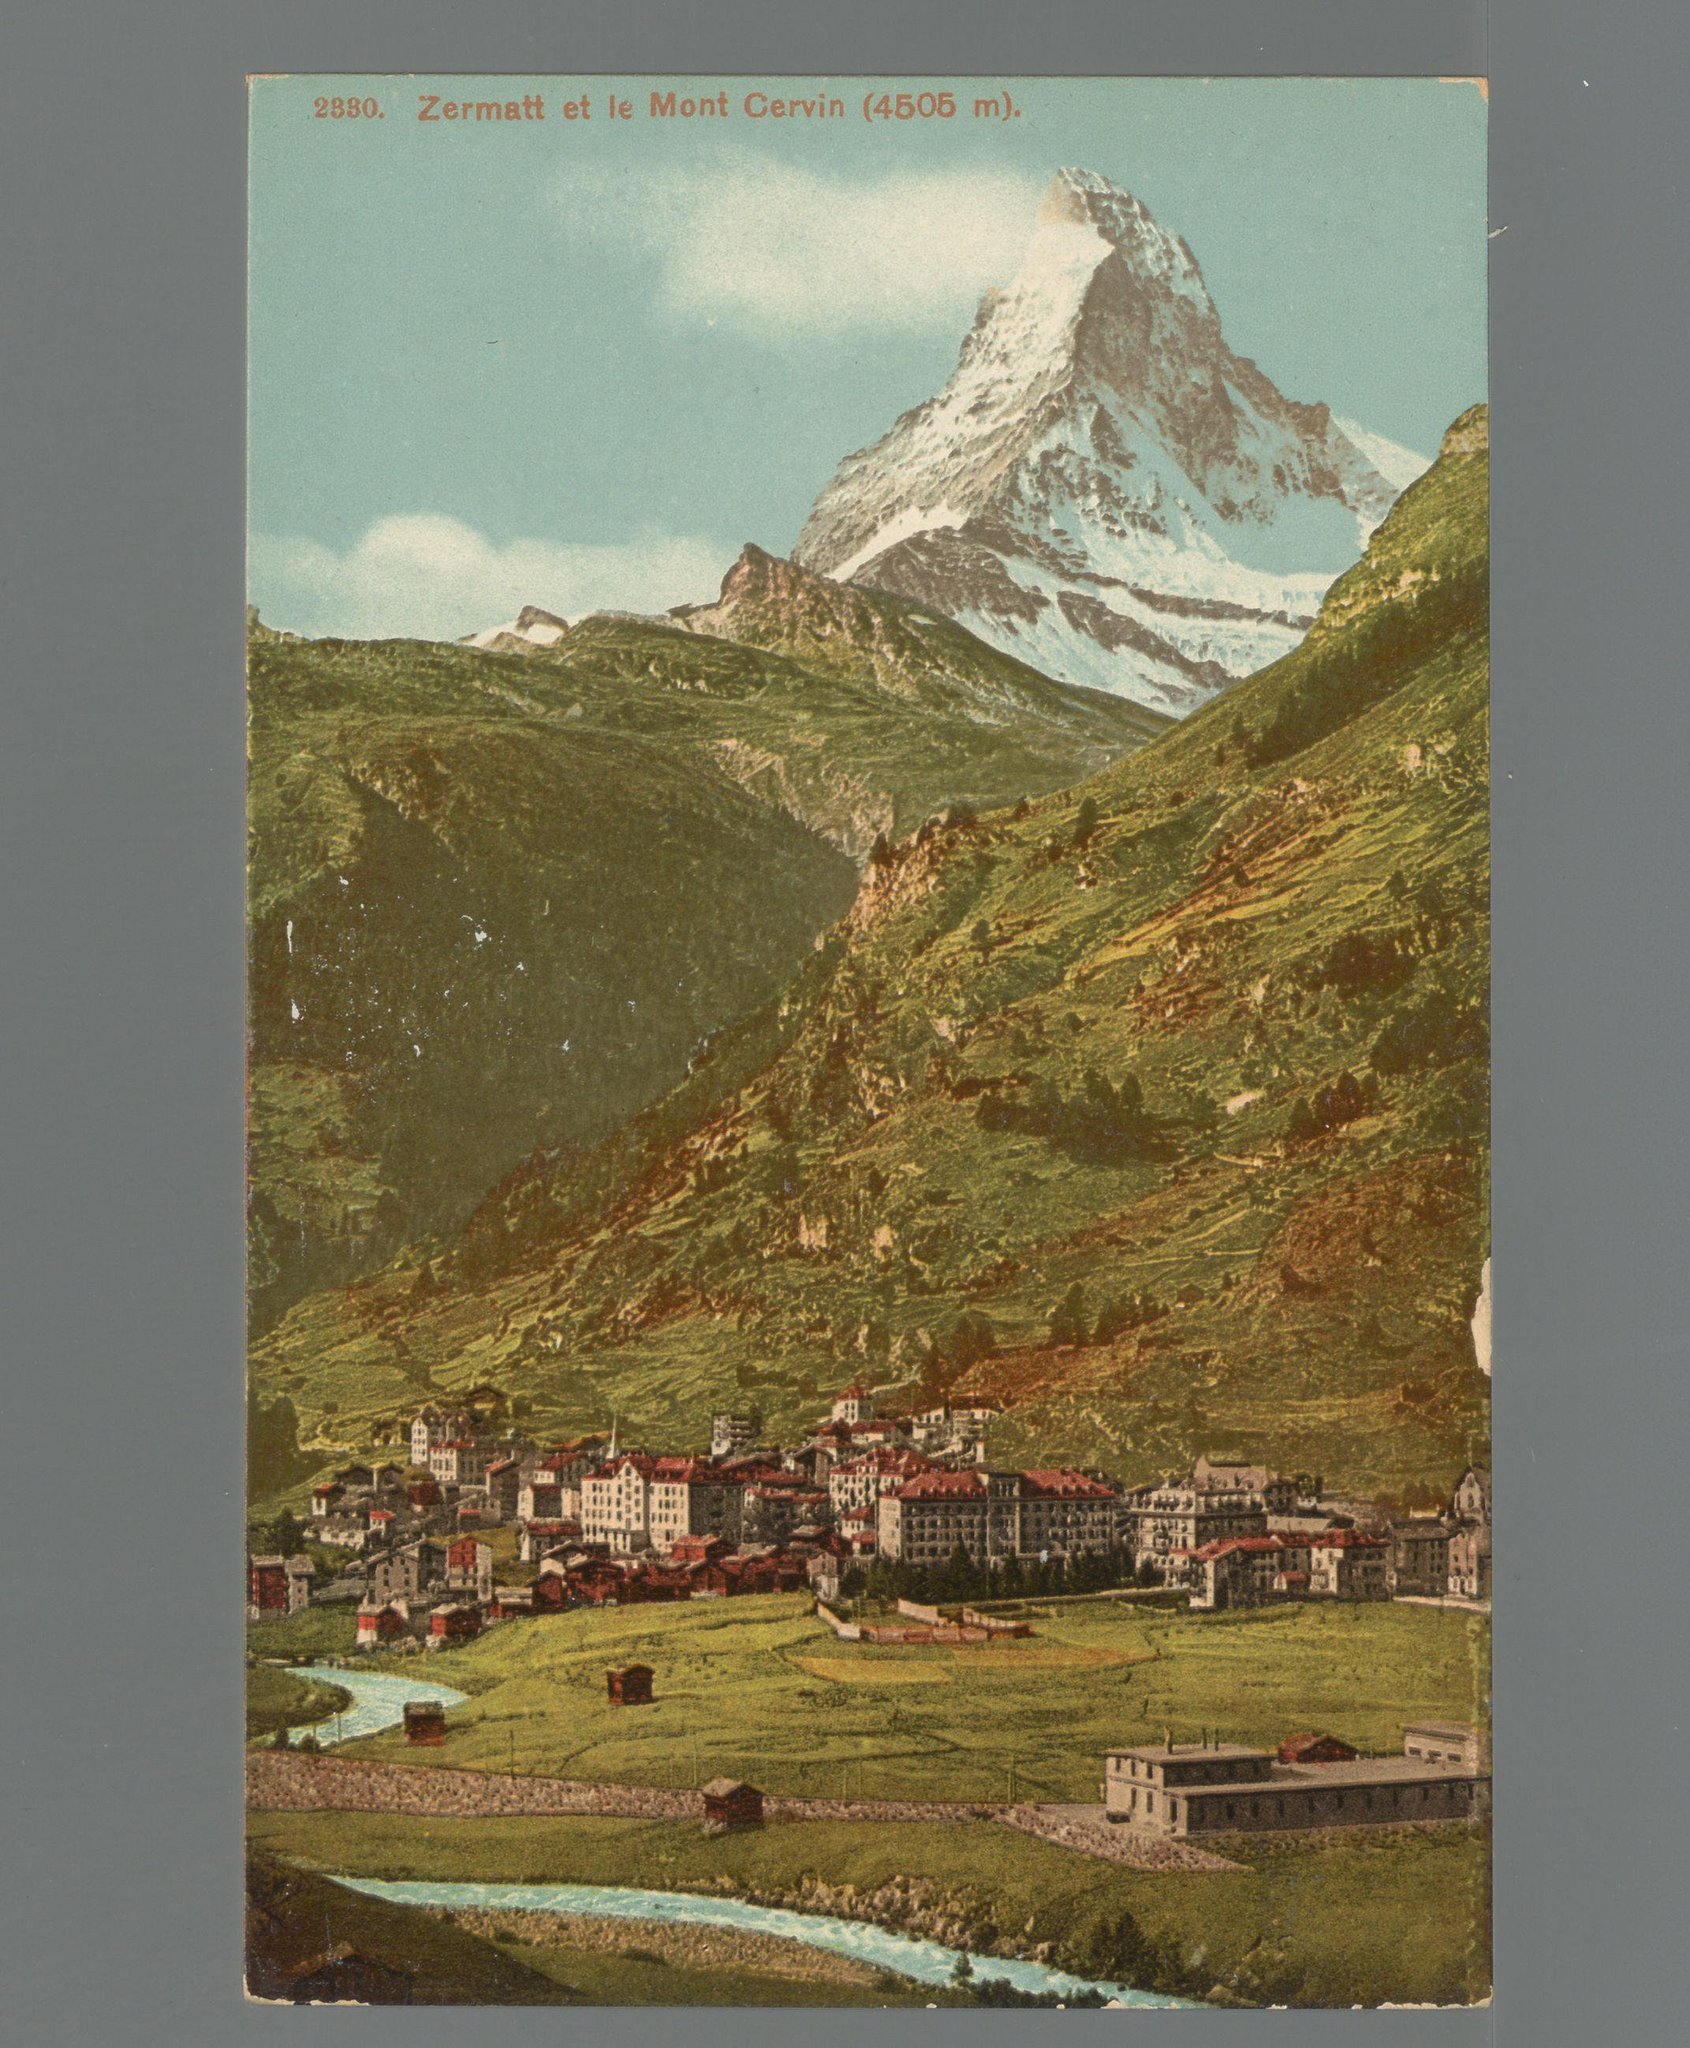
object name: ansichtkaart, prentbriefkaart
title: Zermatt et le Mont Cervin (4505 m)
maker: Anonymous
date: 1903-1904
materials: cardboard, photographic process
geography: zurich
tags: prospect of village, silhouette of village, mountain-range, snow peaks